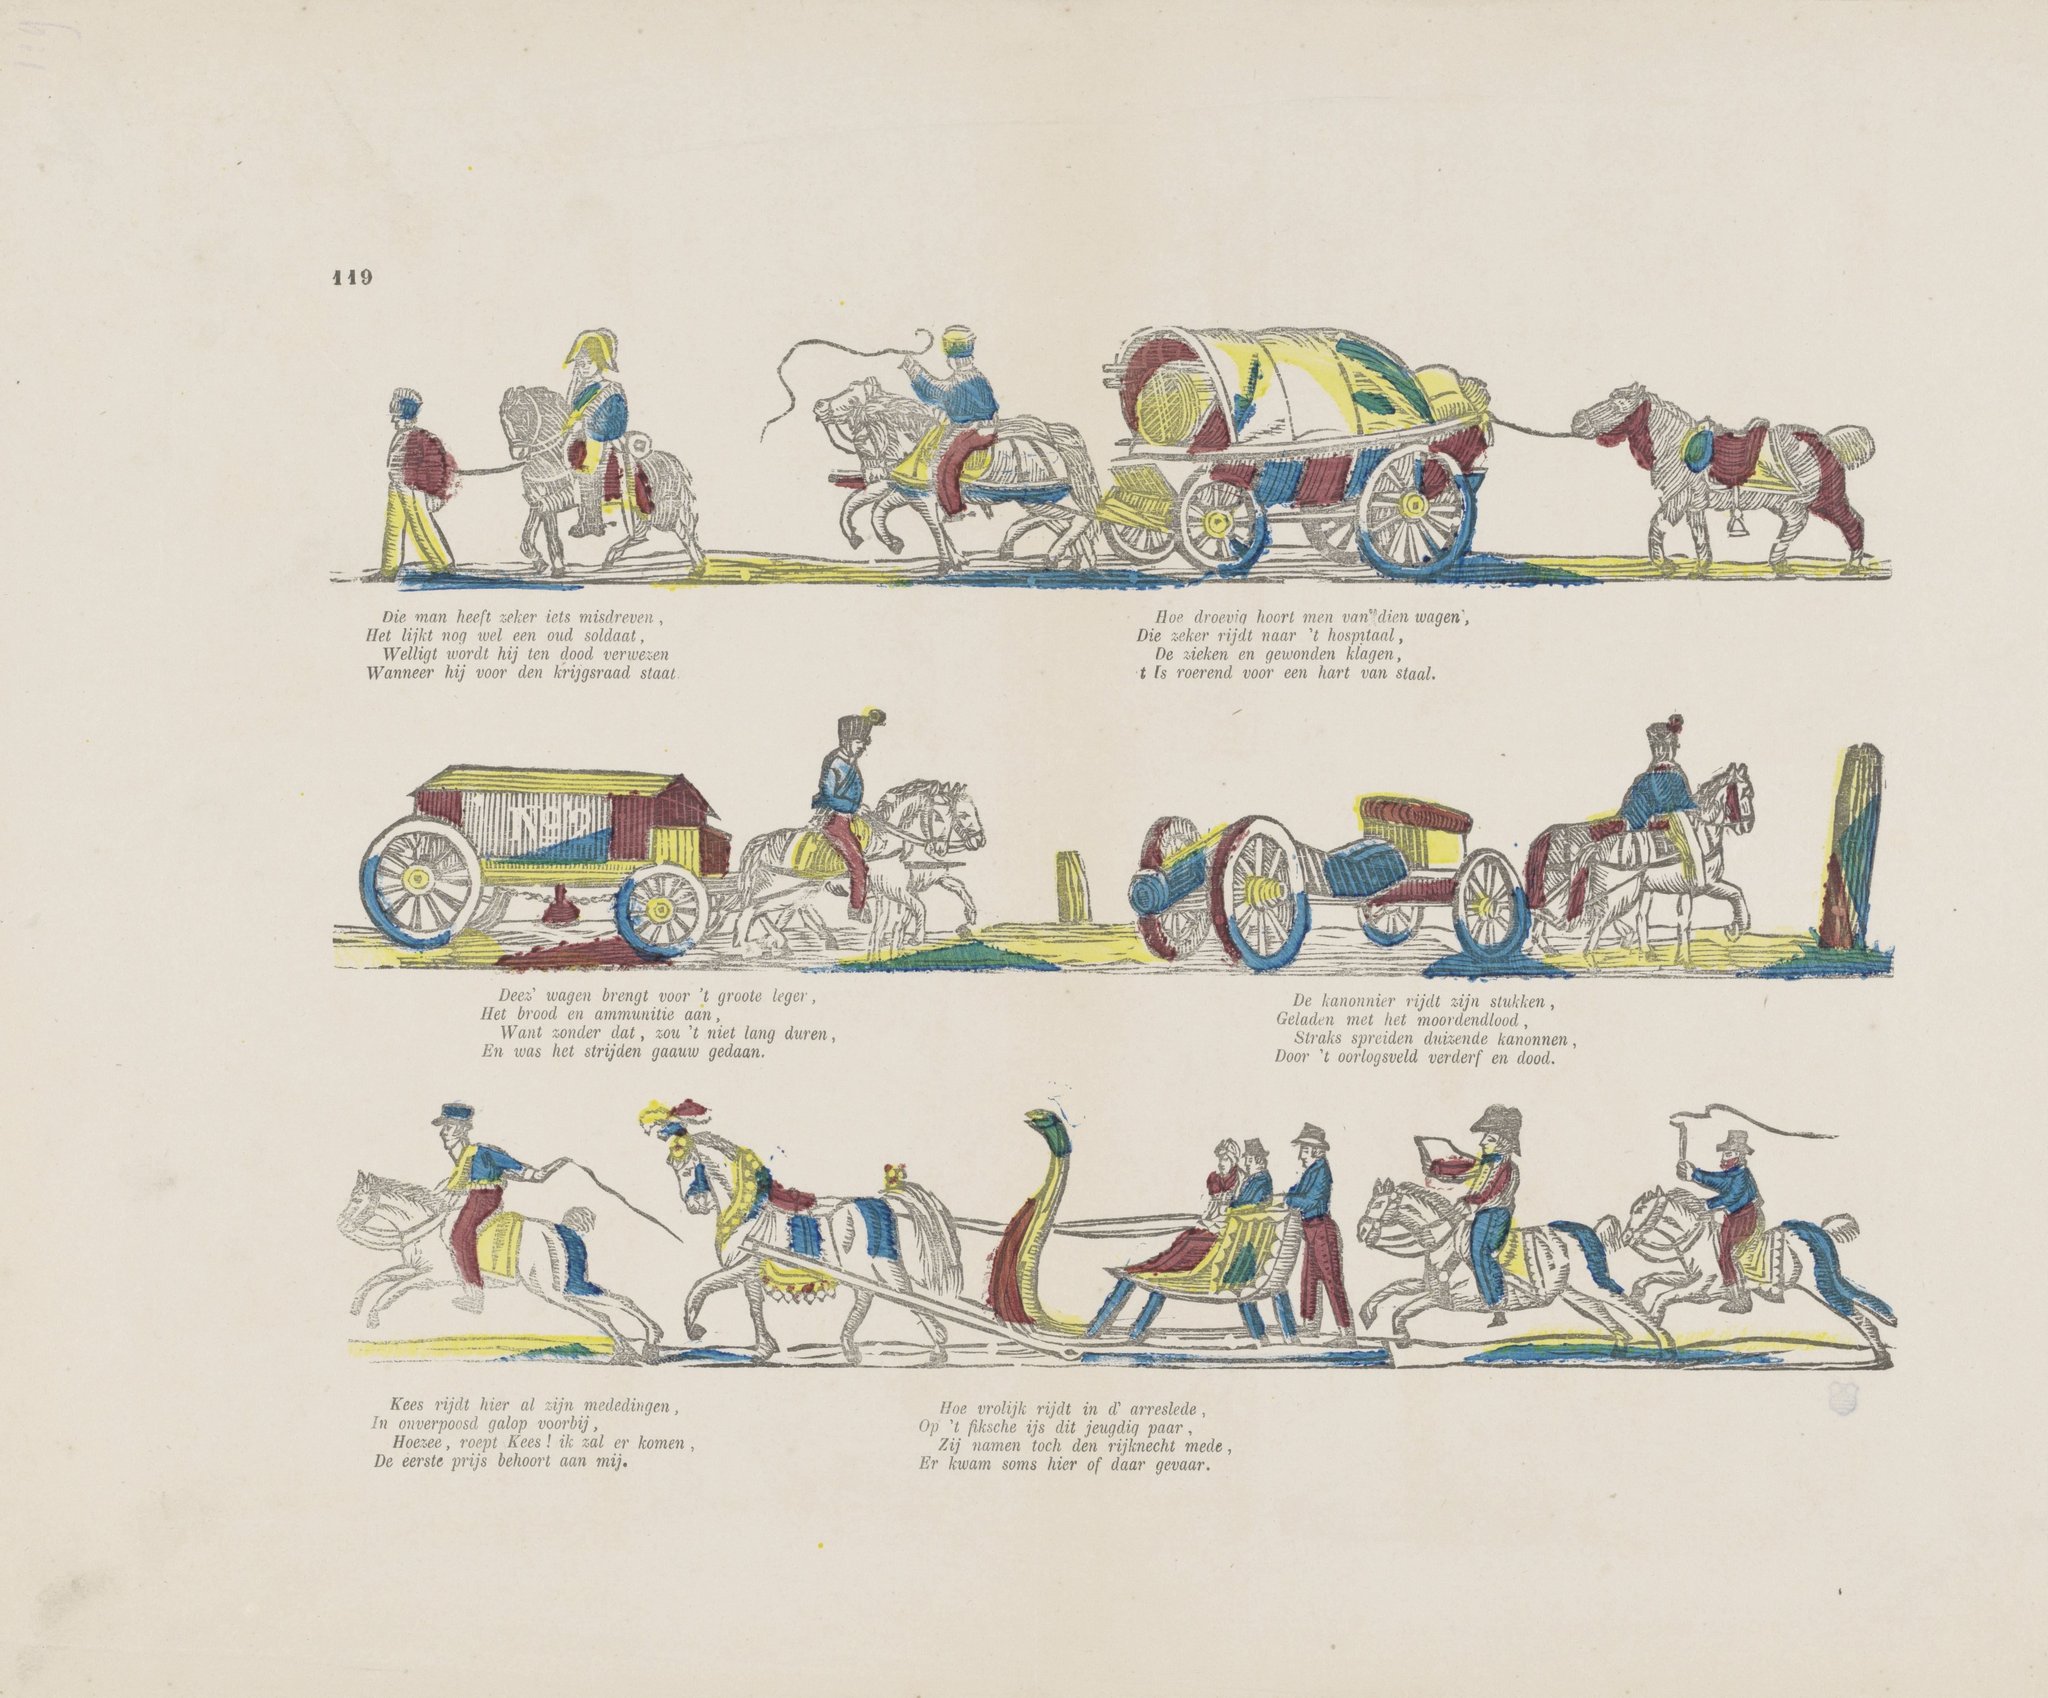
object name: print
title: Vervoermiddelen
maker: Anonymous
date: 1848-1881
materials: paper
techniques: colour, letterpress printing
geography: den bosch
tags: horse-sleigh, four-wheeled, animal-drawn vehicle, e.g.: cab, carriage, coach, horse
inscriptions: collector's mark: Lugt 2760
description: Blad met 3 horizontale rijen met voorstellingen van vervoermiddelen, zoals karren en een slee. Onder elke rij een achtregelig vers in twee kolommen. Genummerd linksboven: 119.